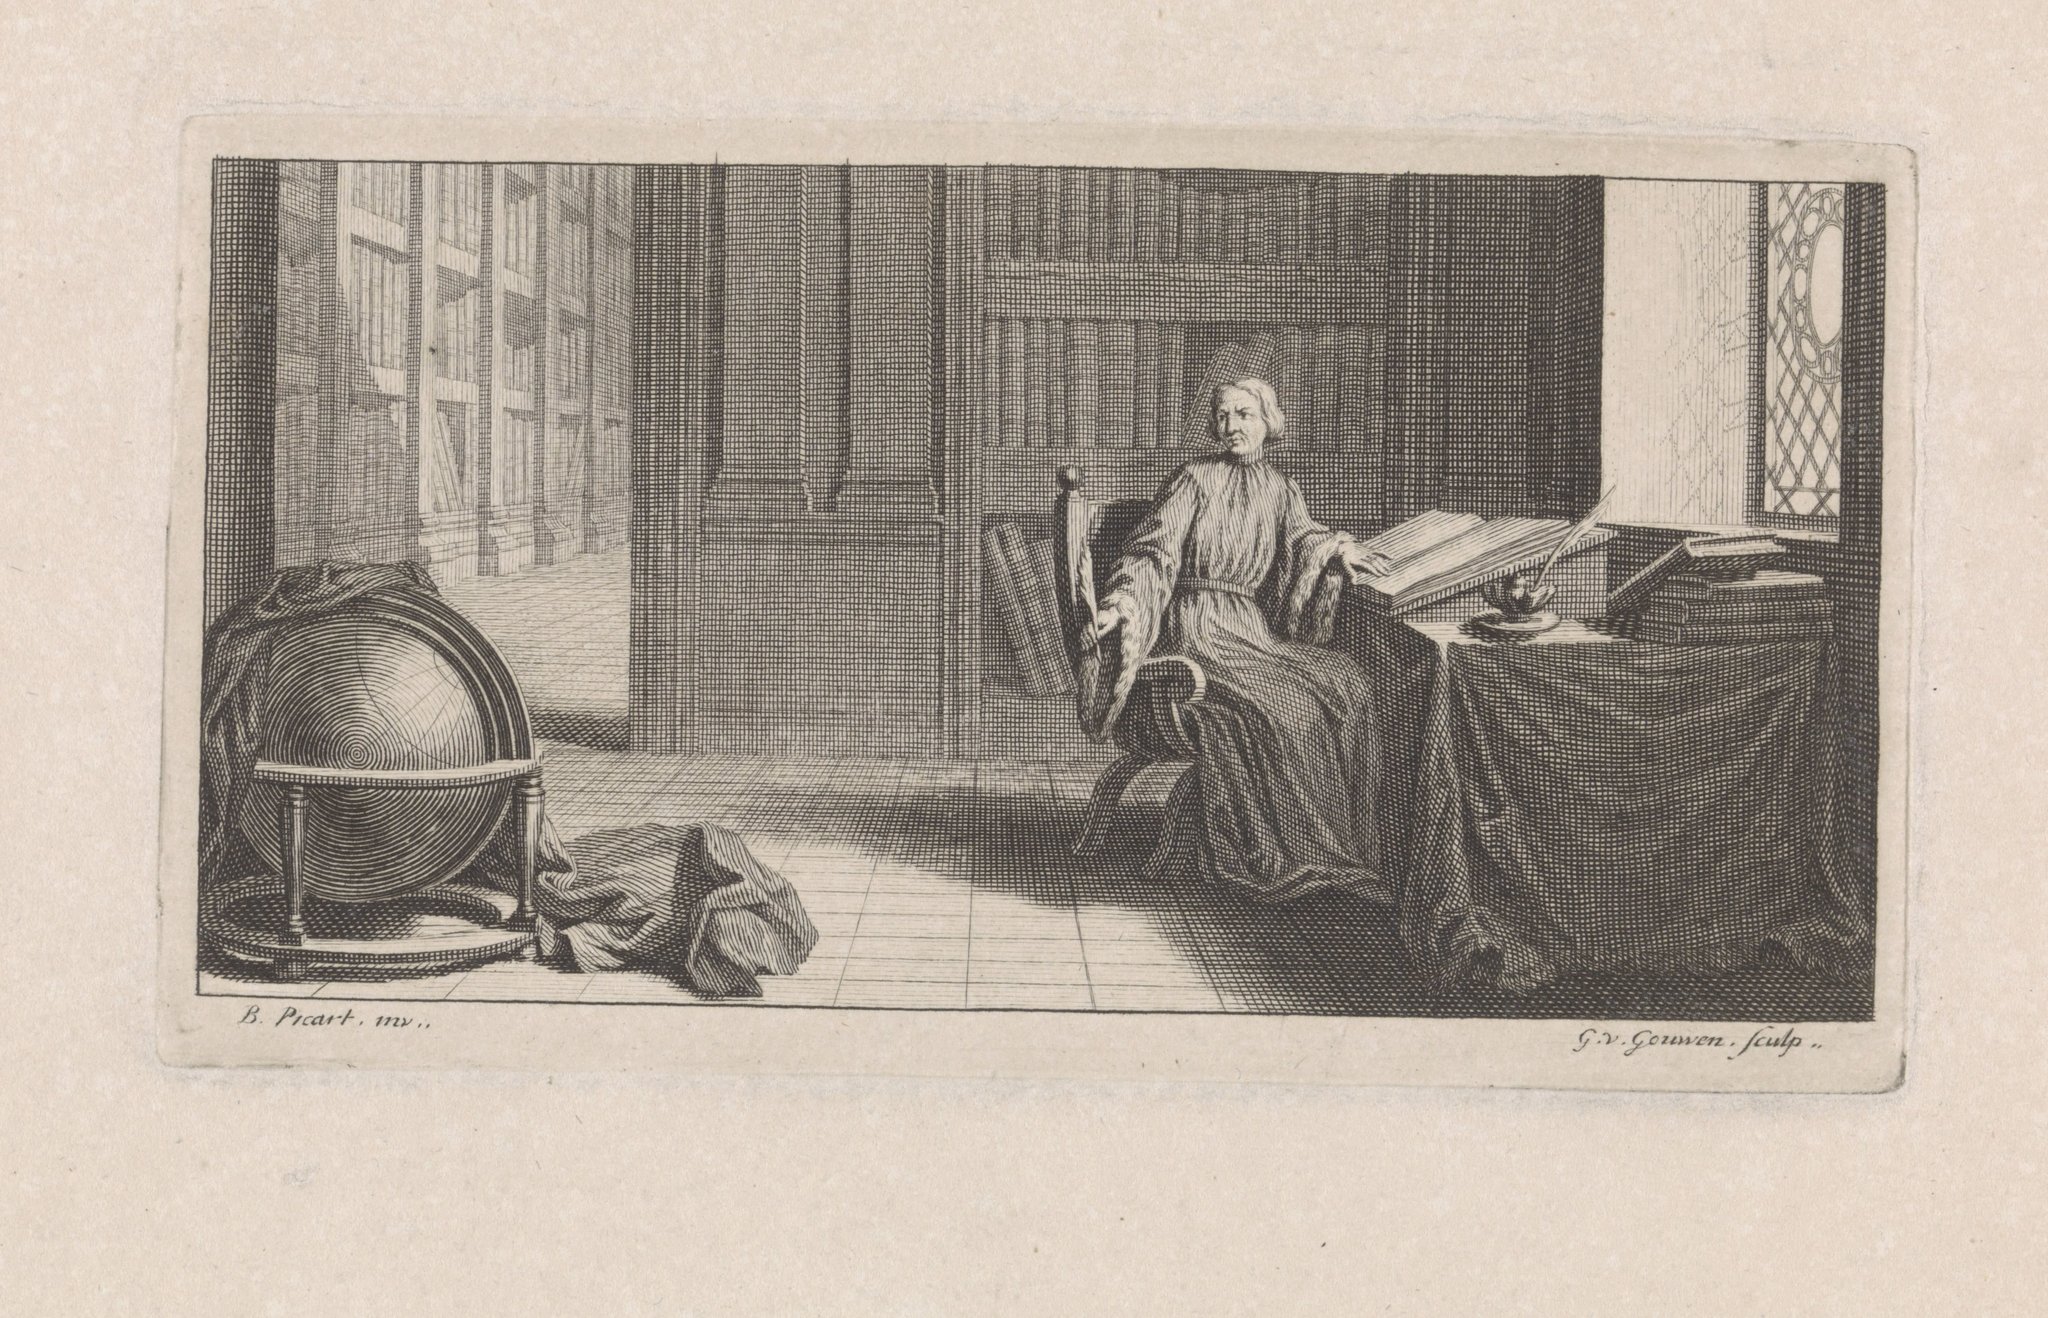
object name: print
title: Geleerde in zijn studievertrek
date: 1670-1740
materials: paper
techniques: engraving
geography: amsterdam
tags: scholar in his study, armillary sphere, skeleton celestial globe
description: Een geleerde zit in een studievertrek te schrijven aan zijn bureau. Linksonder een globe.